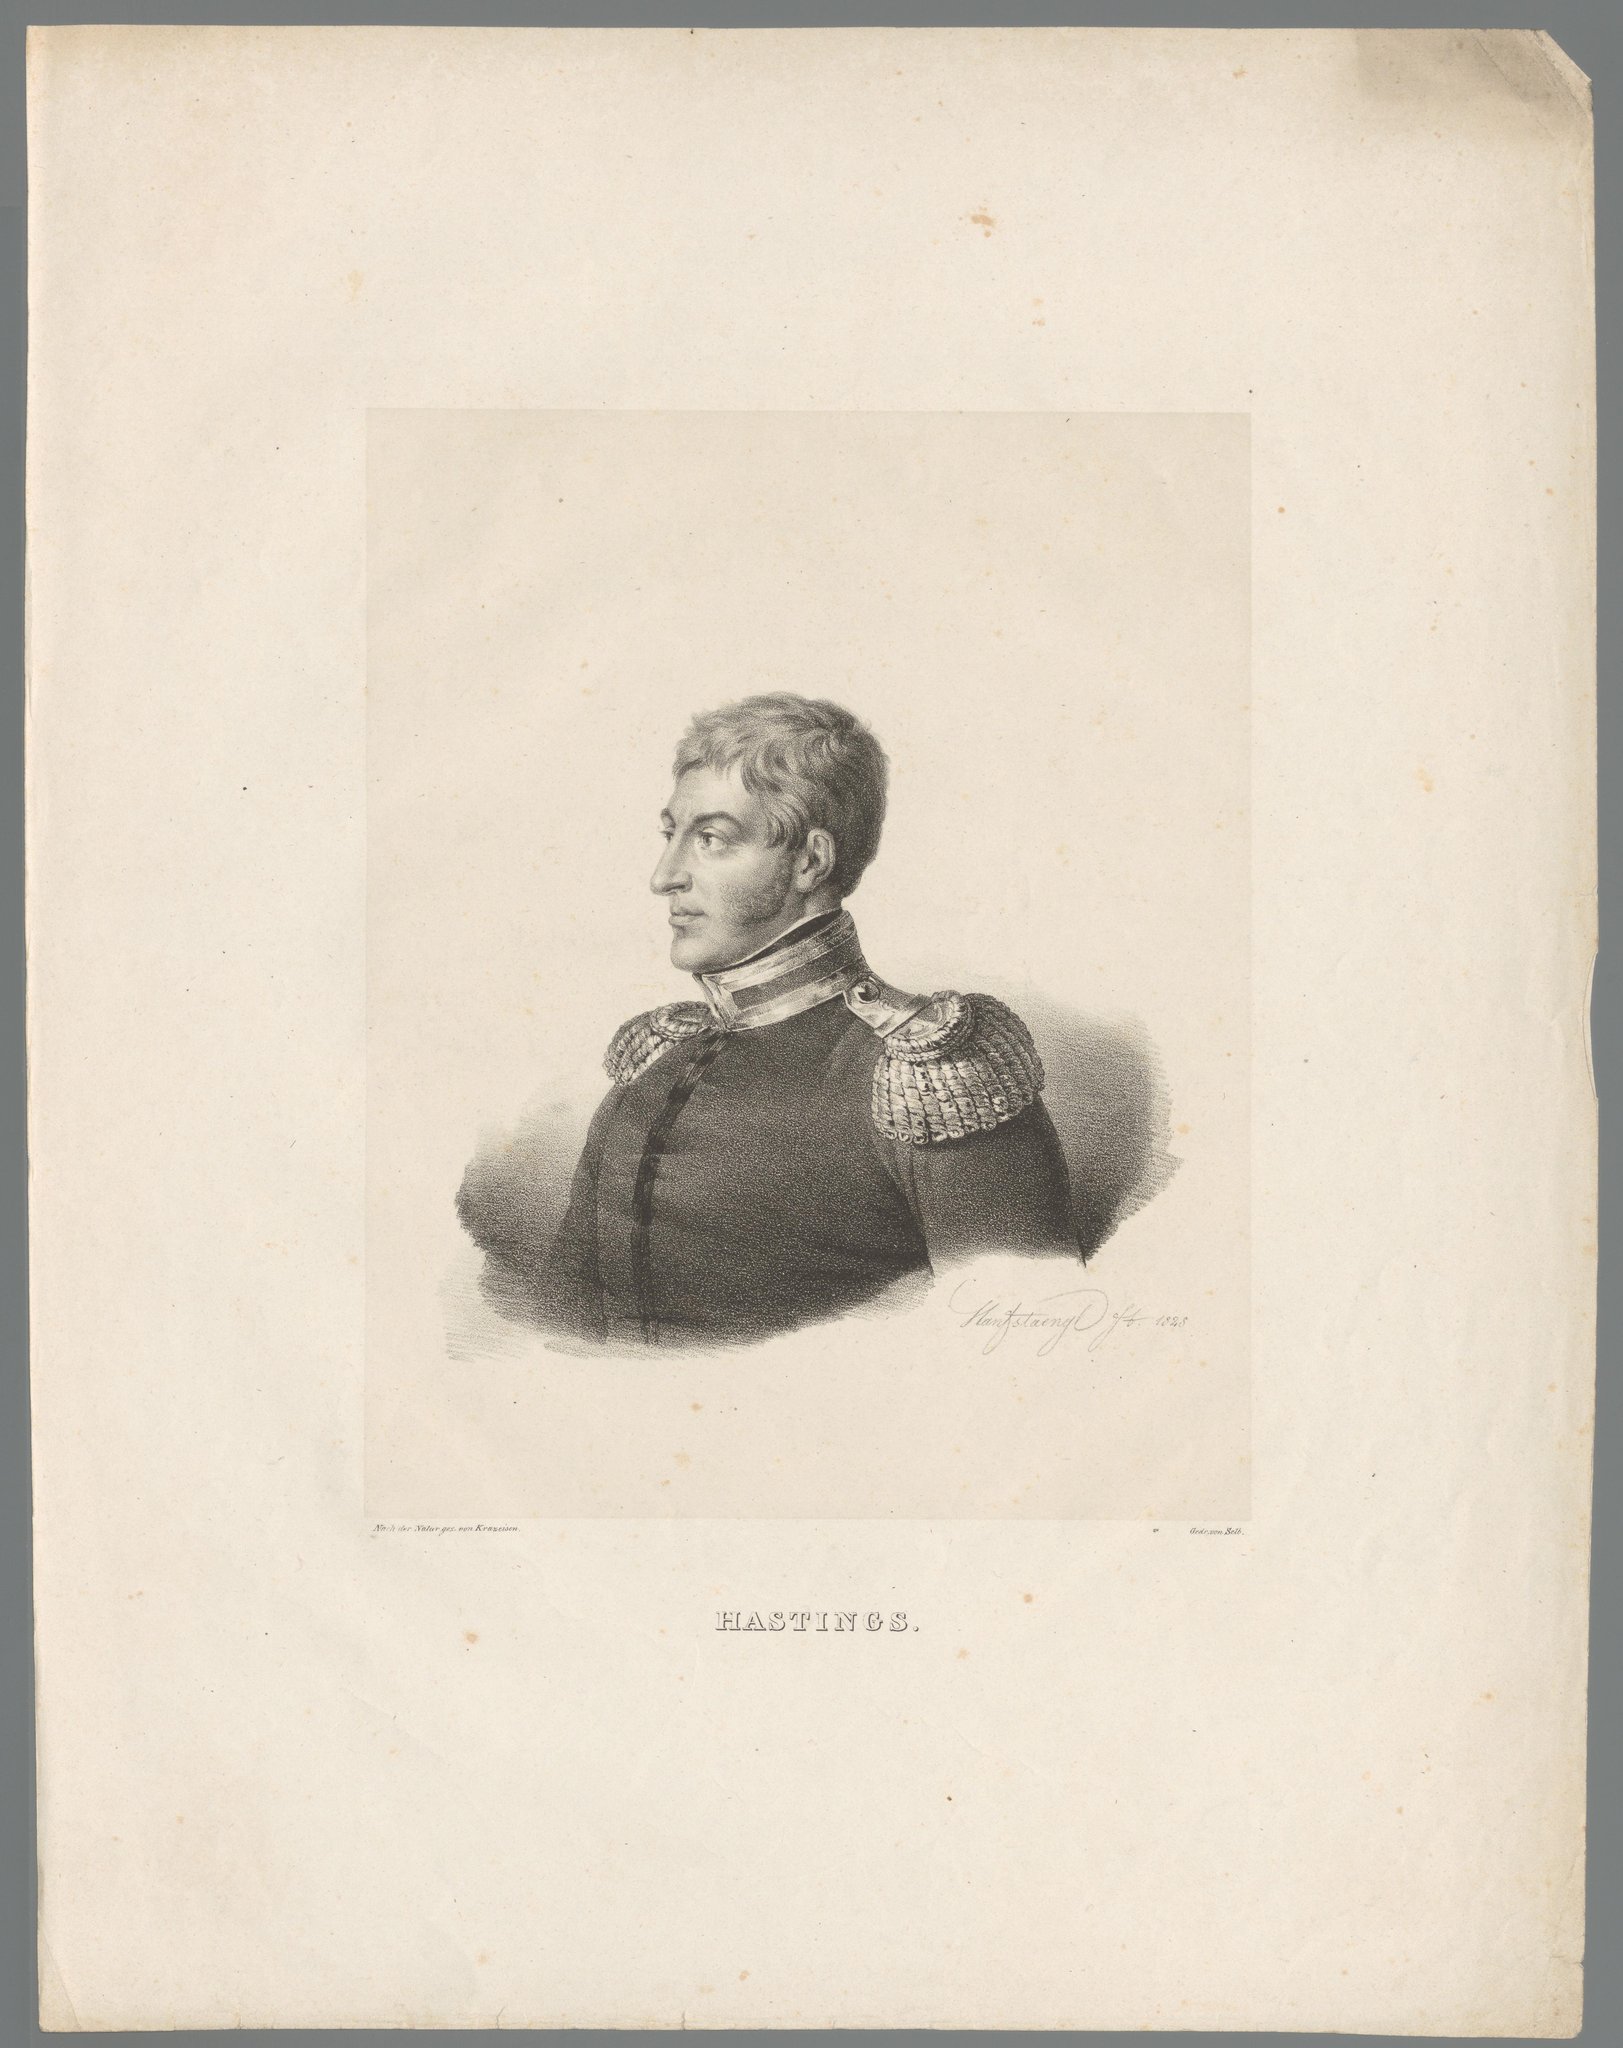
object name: print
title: Hastings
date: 1828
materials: paper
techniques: lithograph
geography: munich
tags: adult man, historical persons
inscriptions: collector's mark: Lugt 2228